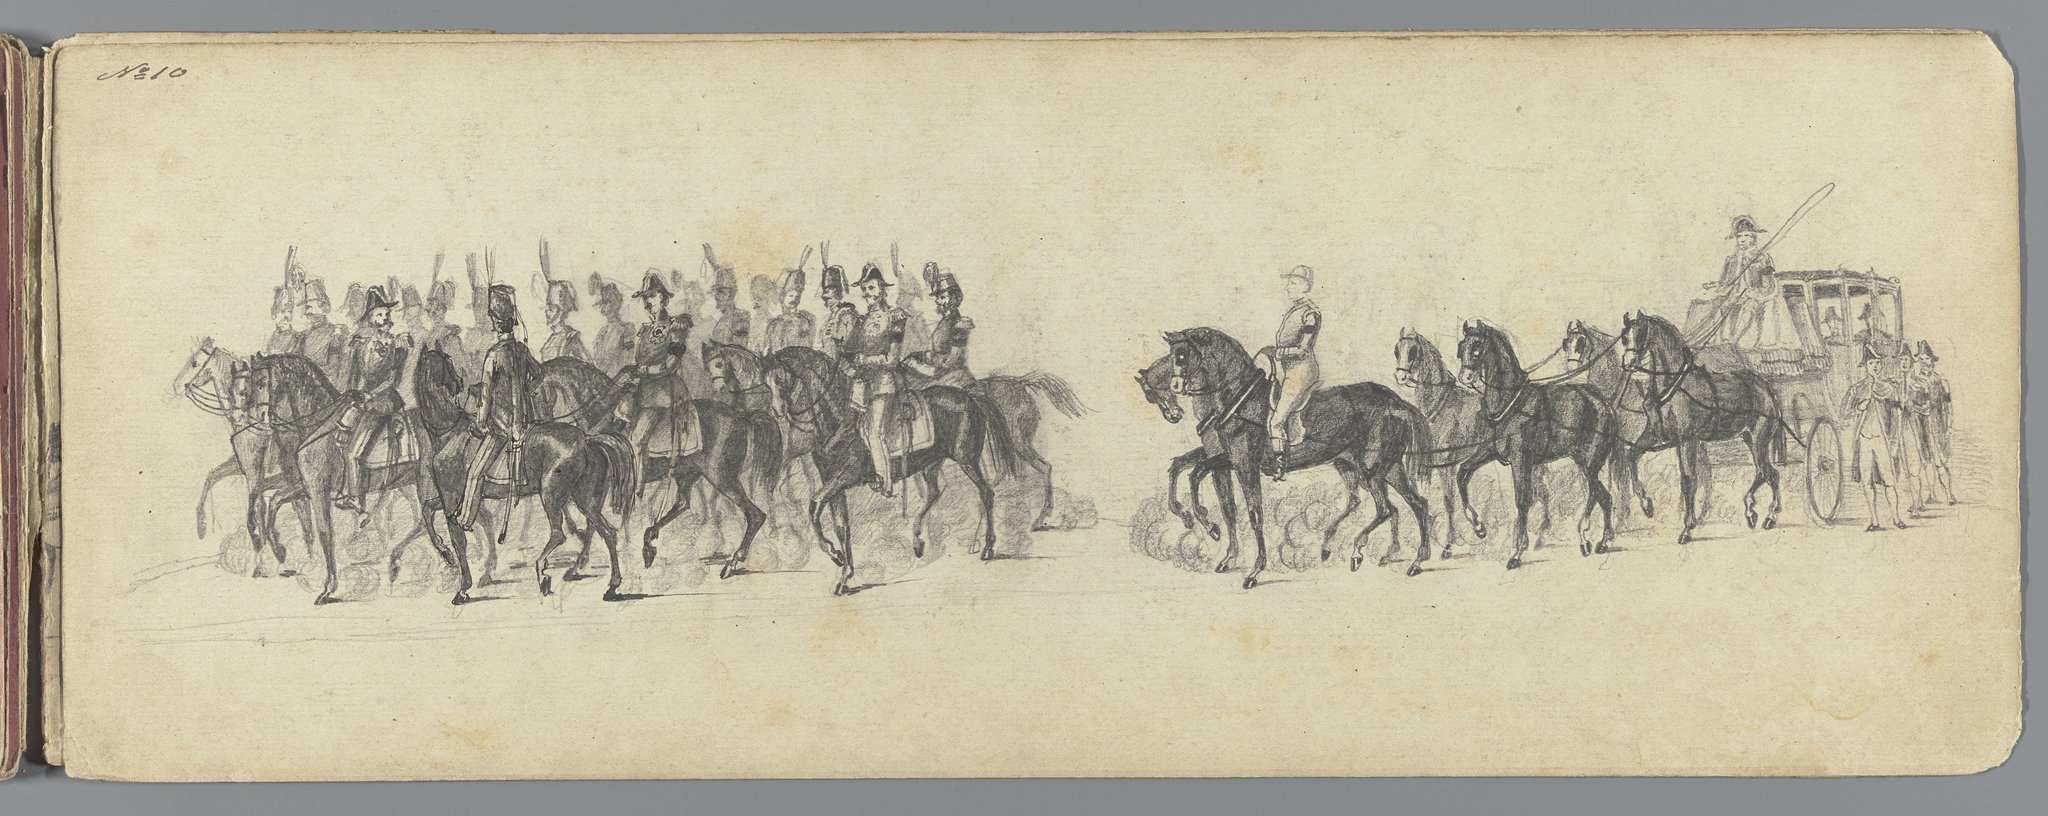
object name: drawing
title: Begrafenisstoet van Anna Paulowna (blad 10), 1865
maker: Anonymous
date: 1865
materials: paper, pencil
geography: netherlands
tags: anna paulowna romanowa, cortege, funeral procession, four-wheeled vehicle drawn by more than three animals, delft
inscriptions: inscription: ‘No. 10’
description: Een groep ruiters voor het koninklijke rijtuig met leden van de koninklijke familie. Tiende tafereel in een schetsboek met een weergave van de begrafenisstoet van wijlen koningin Anna Paulowna te Delft op 17 maart 1865, omslag met tien losse bladen.